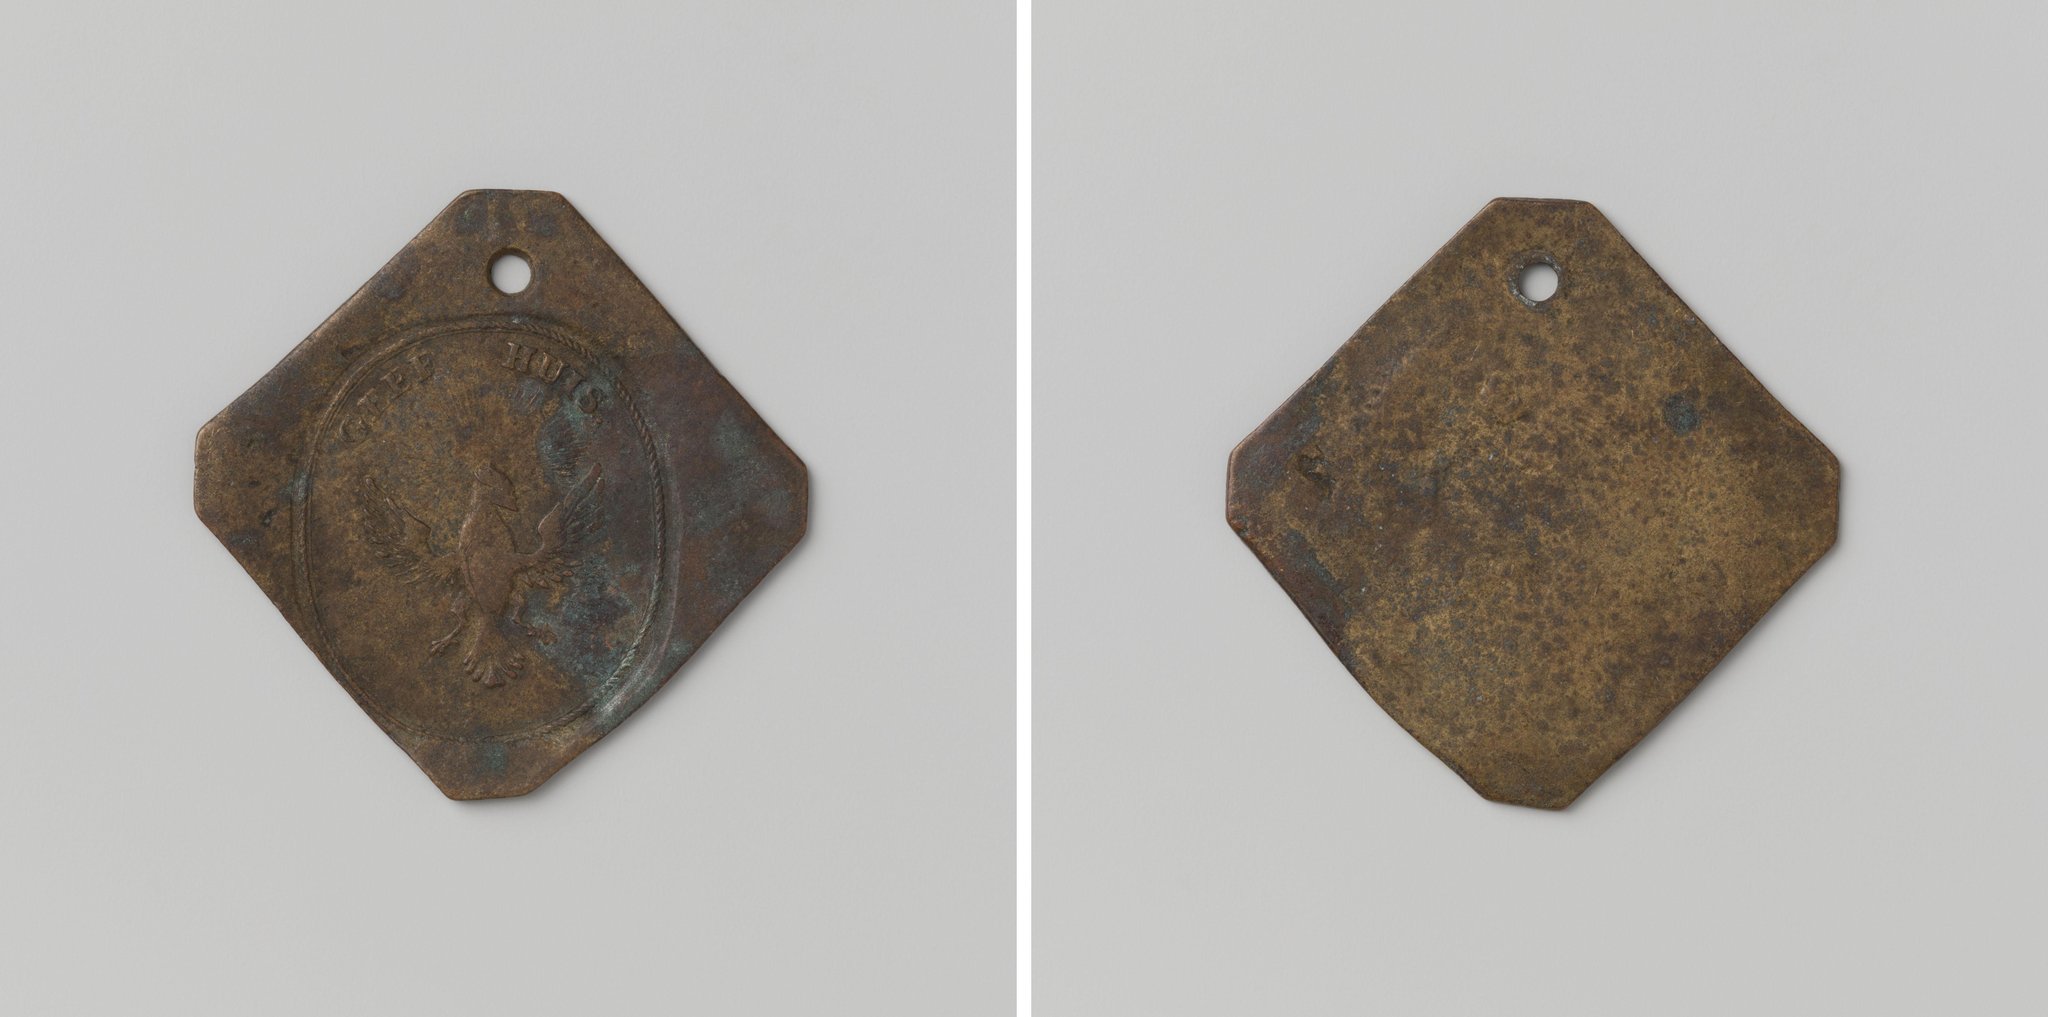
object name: armenloodje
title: Geefhuis te Gouda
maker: Anonymous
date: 1600-1700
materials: brass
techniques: striking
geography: gouda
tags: gouda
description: Eenzijdig messing ruitvormig loodje met afgeschuinde hoeken en gat erin. Voorzijde: in ovale parelrand: duif met gespreide vleugels in stralenkrans binnen omschrift. Keerzijde: blanco.